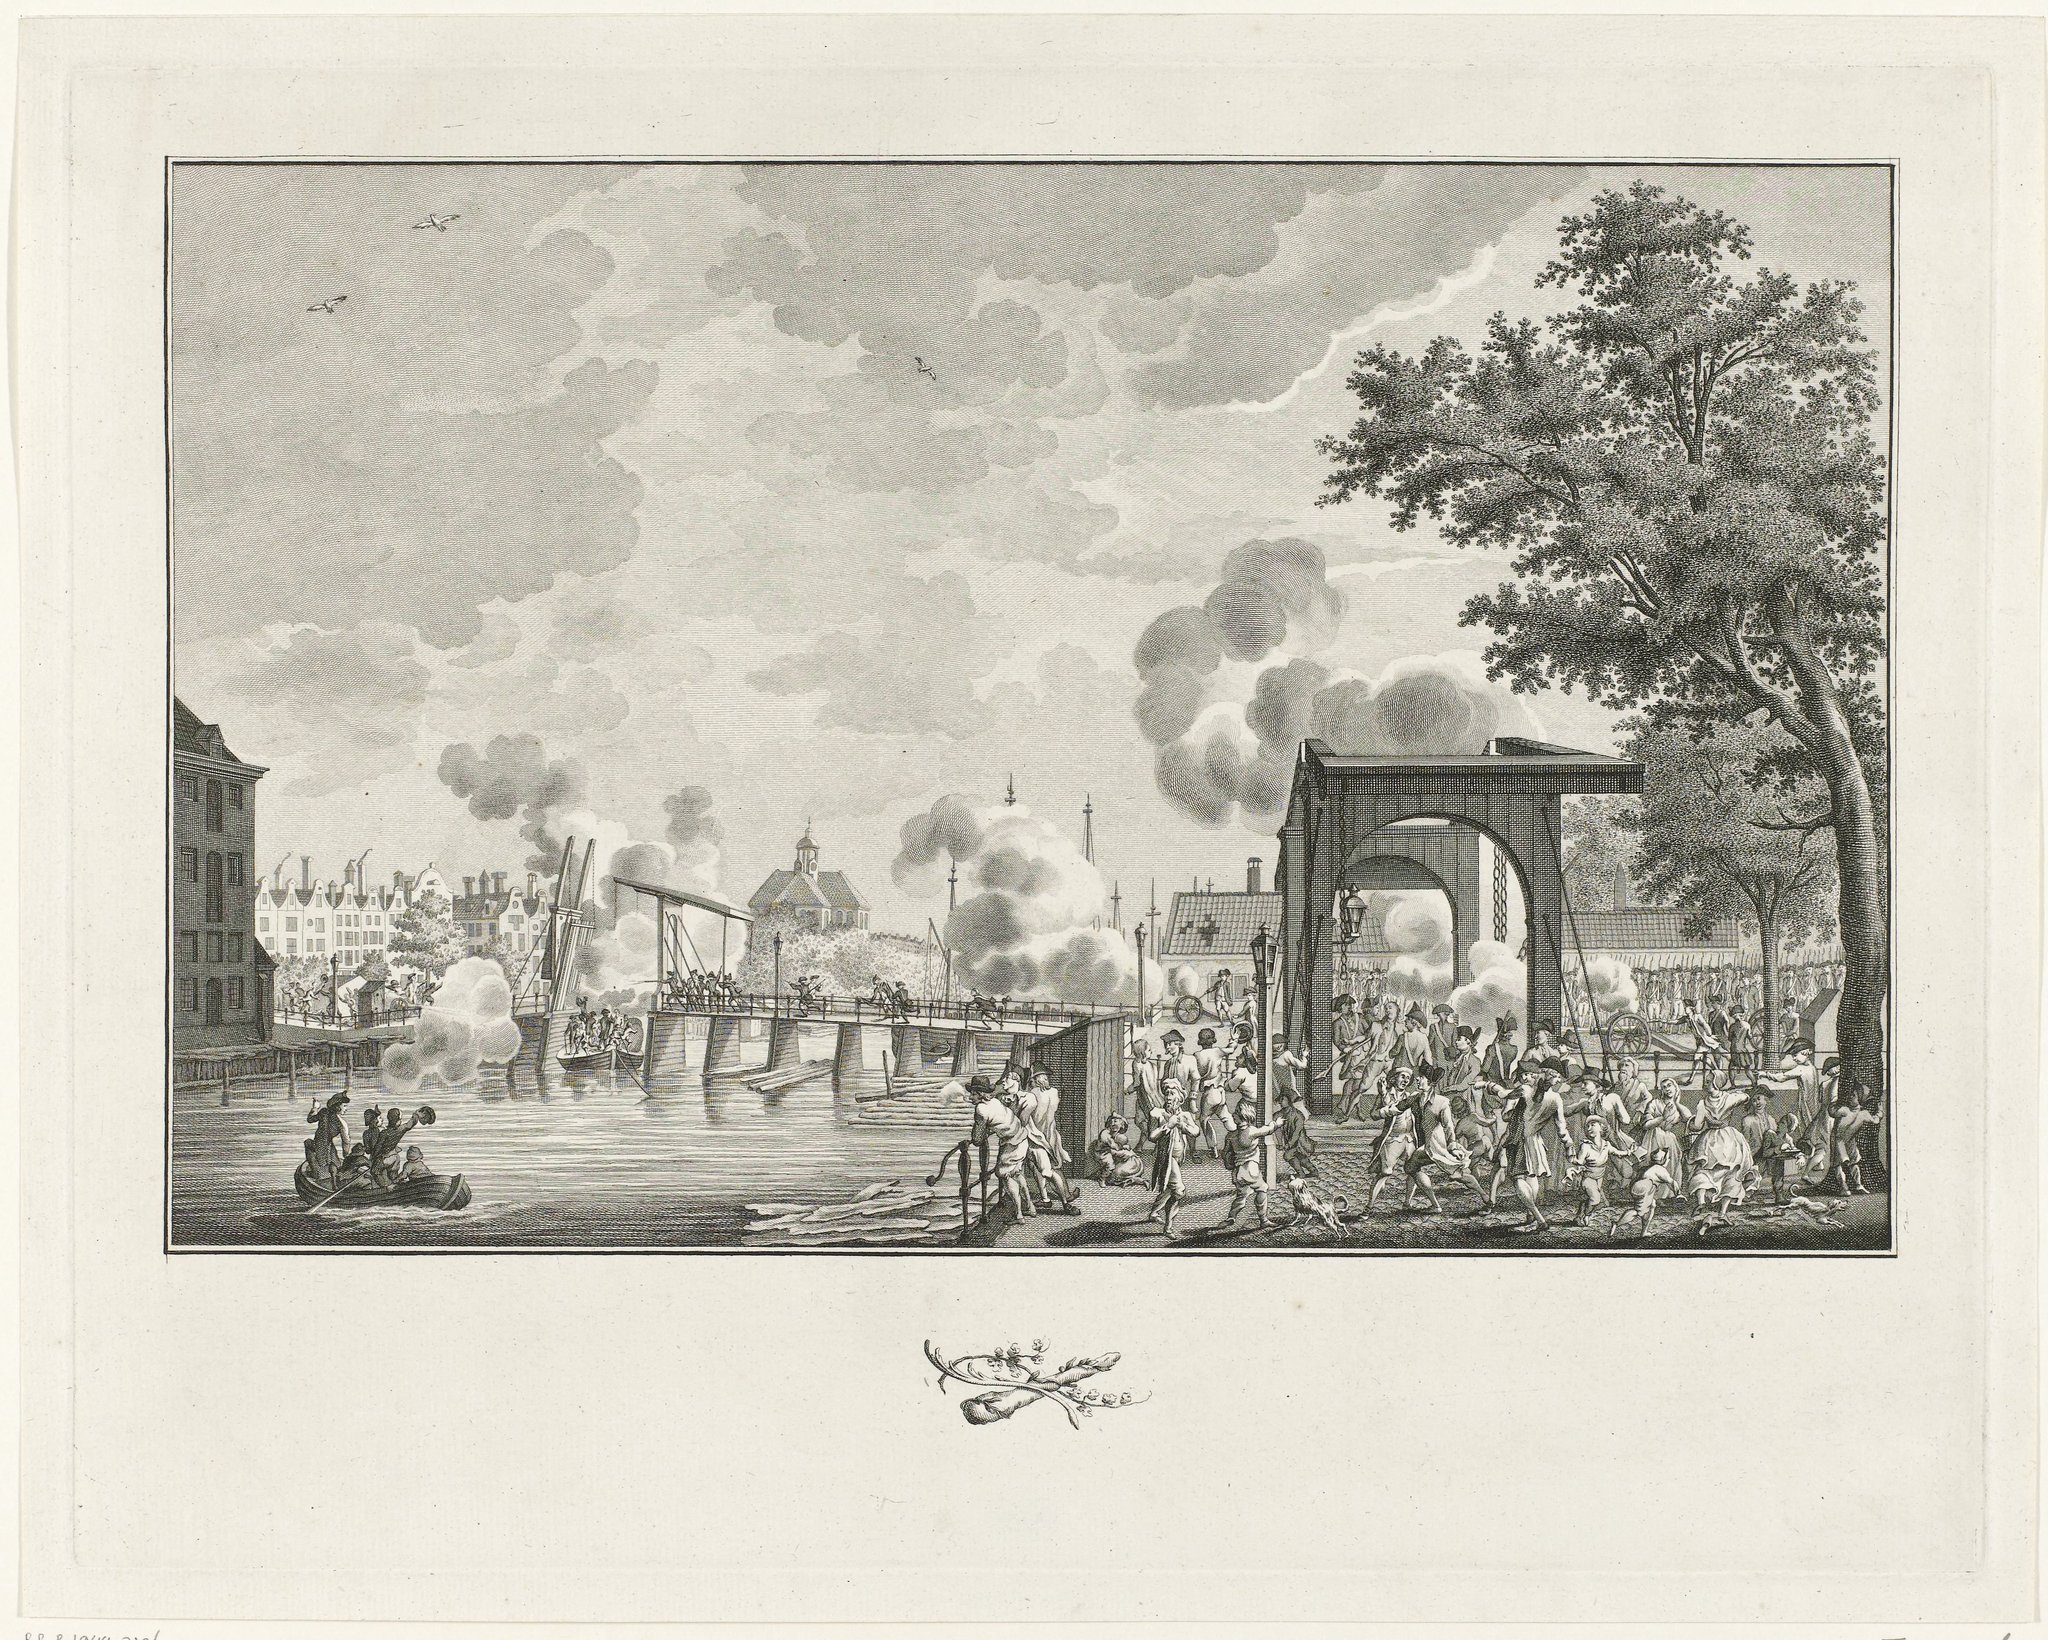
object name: print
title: Verovering van Kattenburg, 1787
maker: carel jacob de huyser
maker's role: print maker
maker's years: 1743-1804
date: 1787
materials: paper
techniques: engraving, etching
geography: northern netherlands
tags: battle (+ citizen soldiery, civil guard, citizen militia)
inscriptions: collector's mark: Lugt 2228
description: De verovering van het eiland Kattenburg op de opstandige Oranjegezinden door de Amsterdamse schutterij en exercitiegenootschap onder bevel van Abraham Valentijn en Hendrik Nobbe, 30 mei 1787. Gezicht op de gevechten rond de twee bruggen die toegang geven tot Kattenburg.